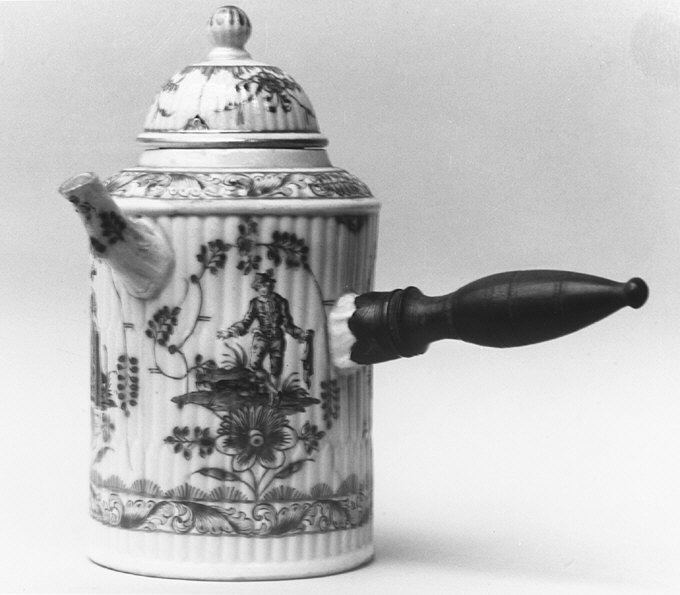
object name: chocolate pot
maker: ludwigsburg porcelain manufactory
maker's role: manufactory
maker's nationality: german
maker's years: 1758-1824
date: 1775-1790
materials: hard paste porcelain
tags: men